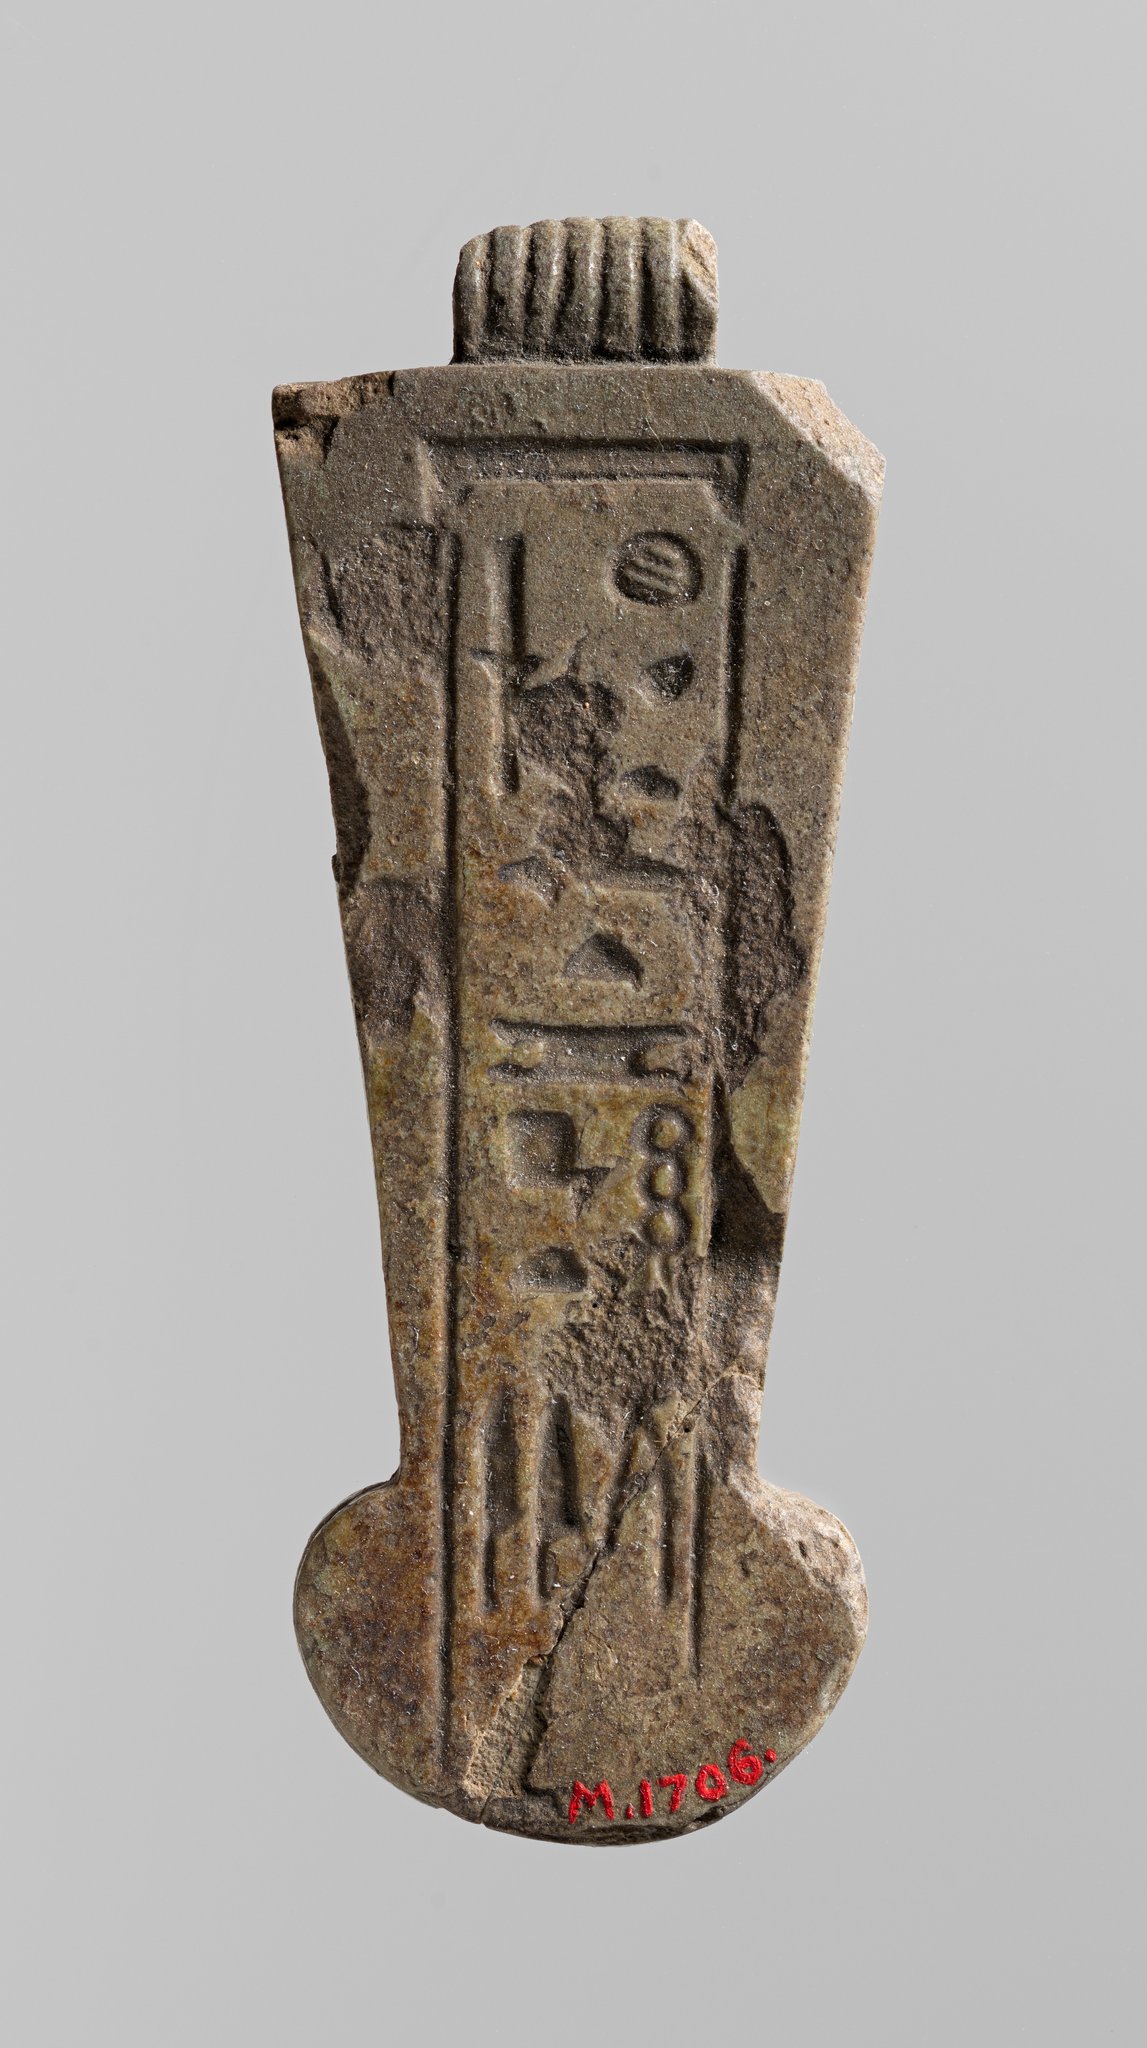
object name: menat pendant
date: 664-332 BCE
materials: limestone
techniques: glazing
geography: egypt